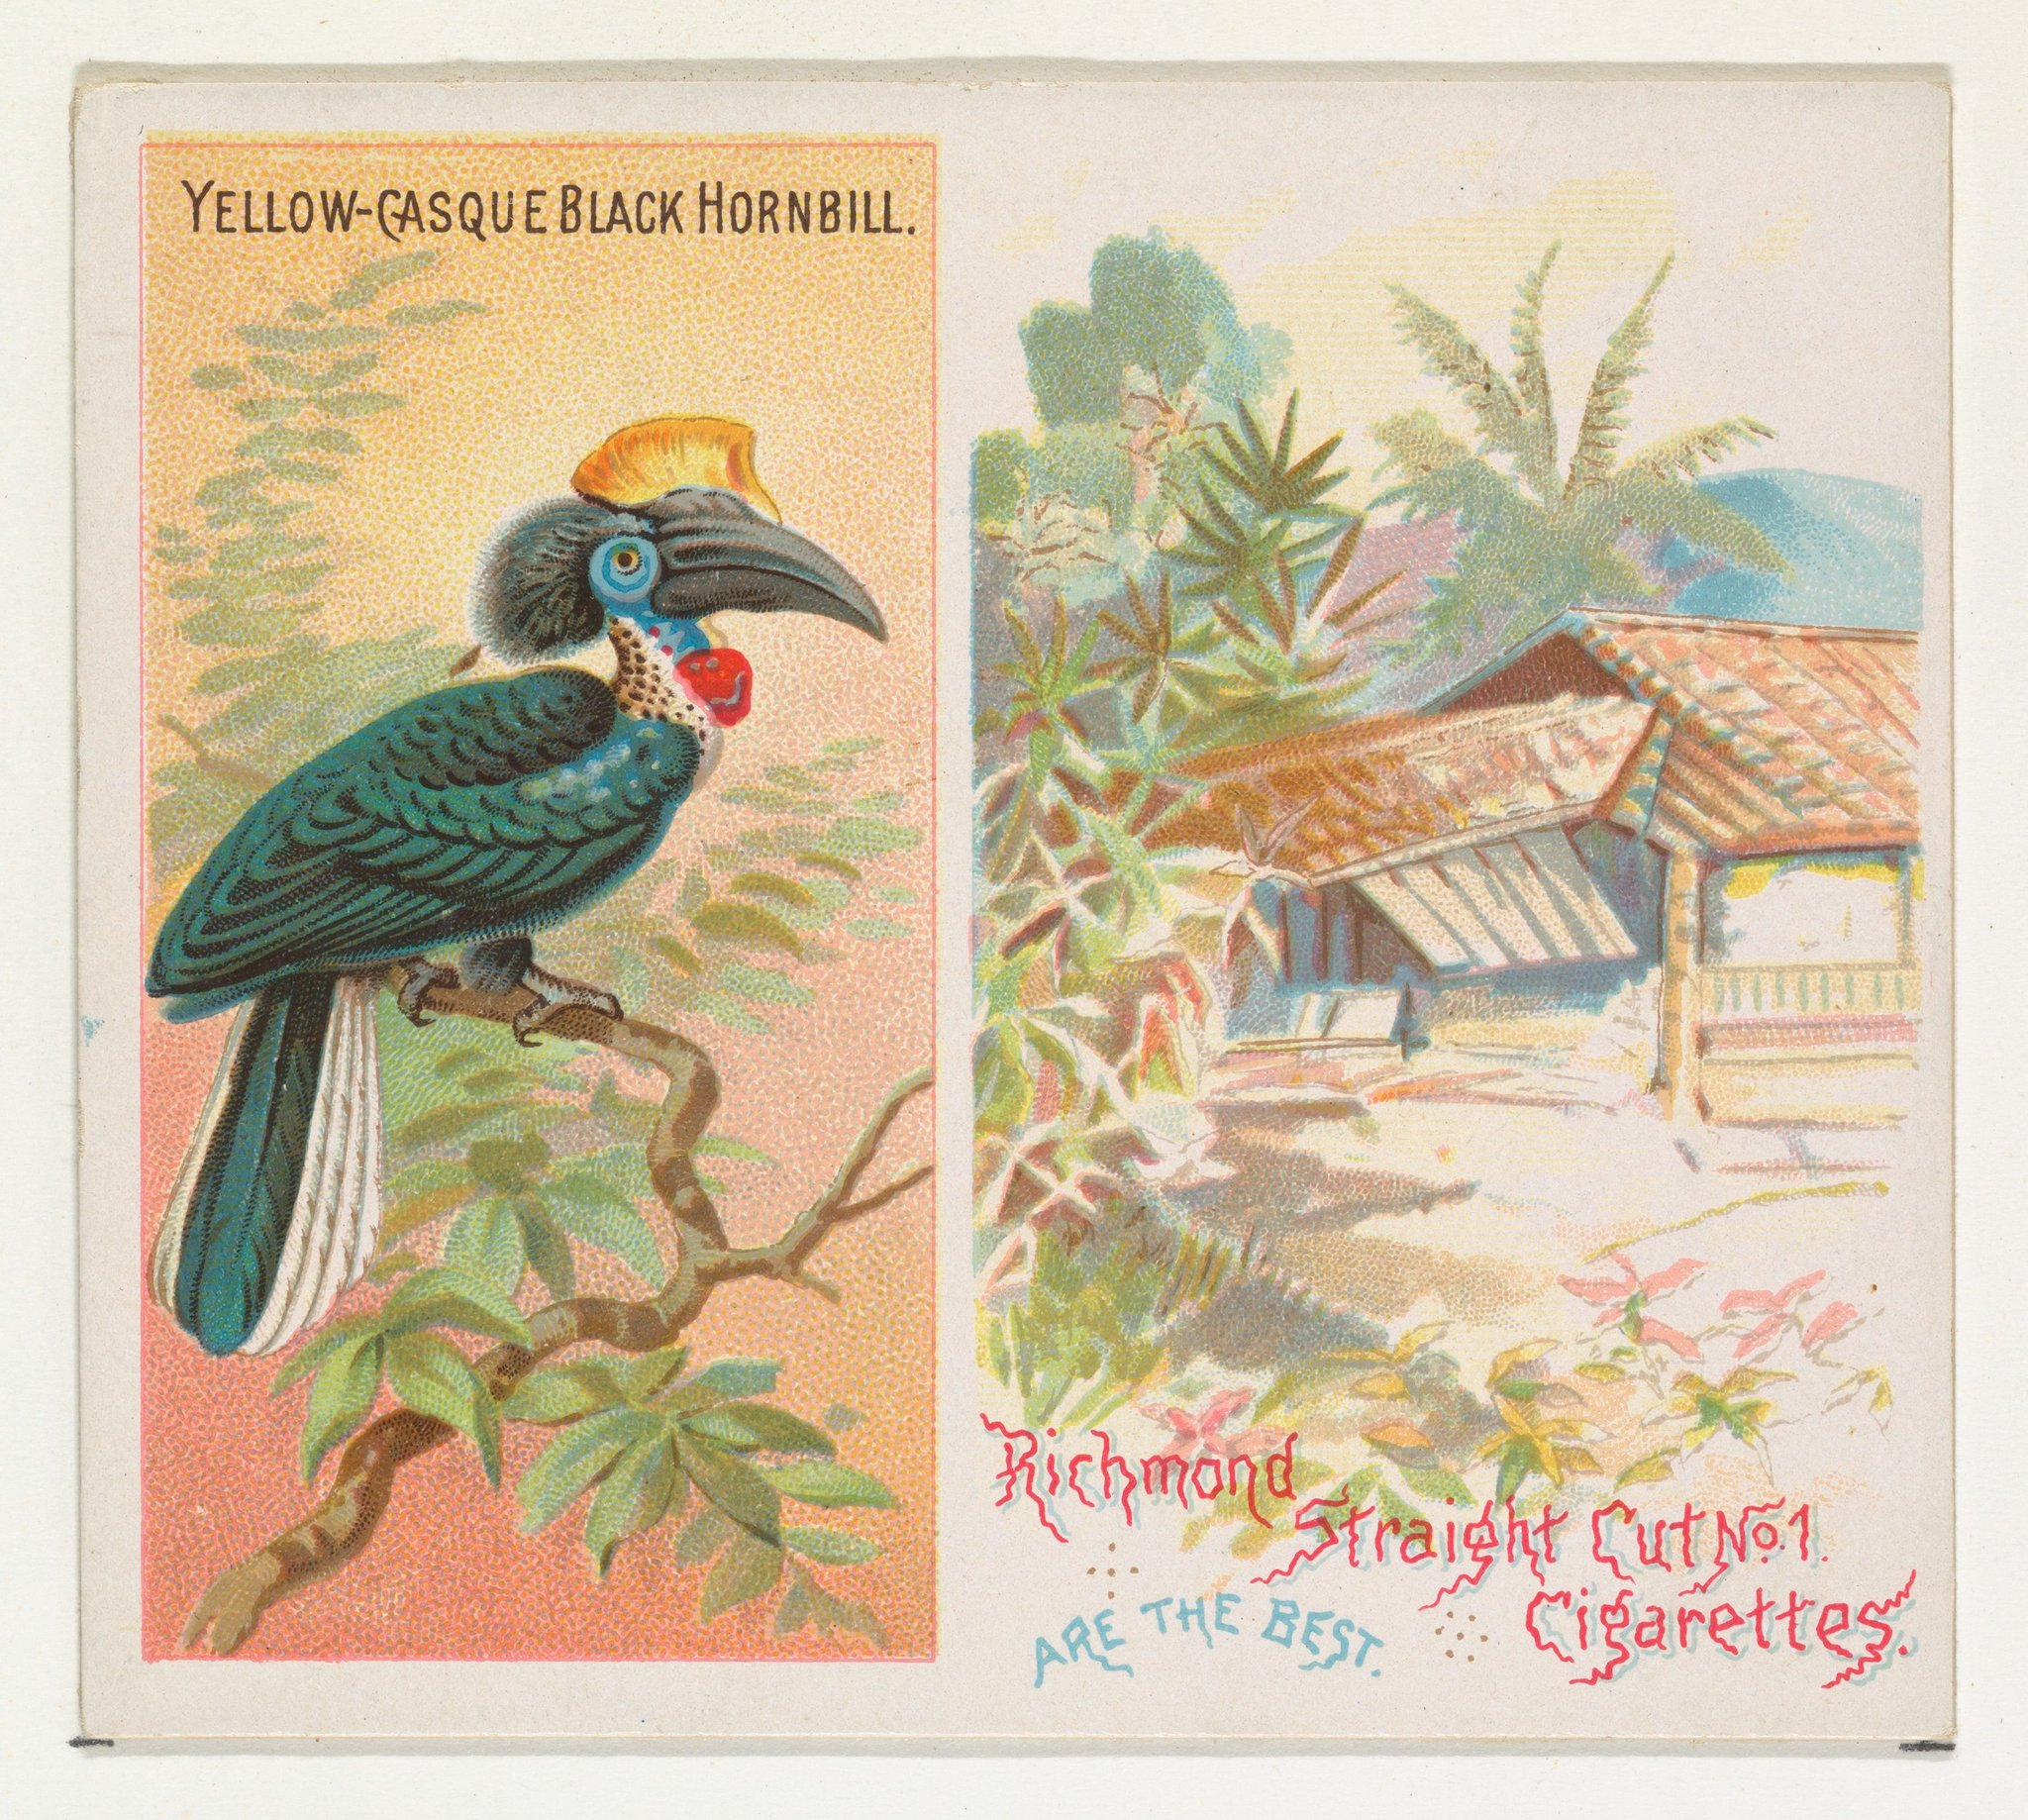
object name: print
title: Yellow-Casque Black Hornbill, from Birds of the Tropics series (N38) for Allen & Ginter Cigarettes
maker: allen & ginter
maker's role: publisher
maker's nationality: american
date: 1889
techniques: color lithograph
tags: birds